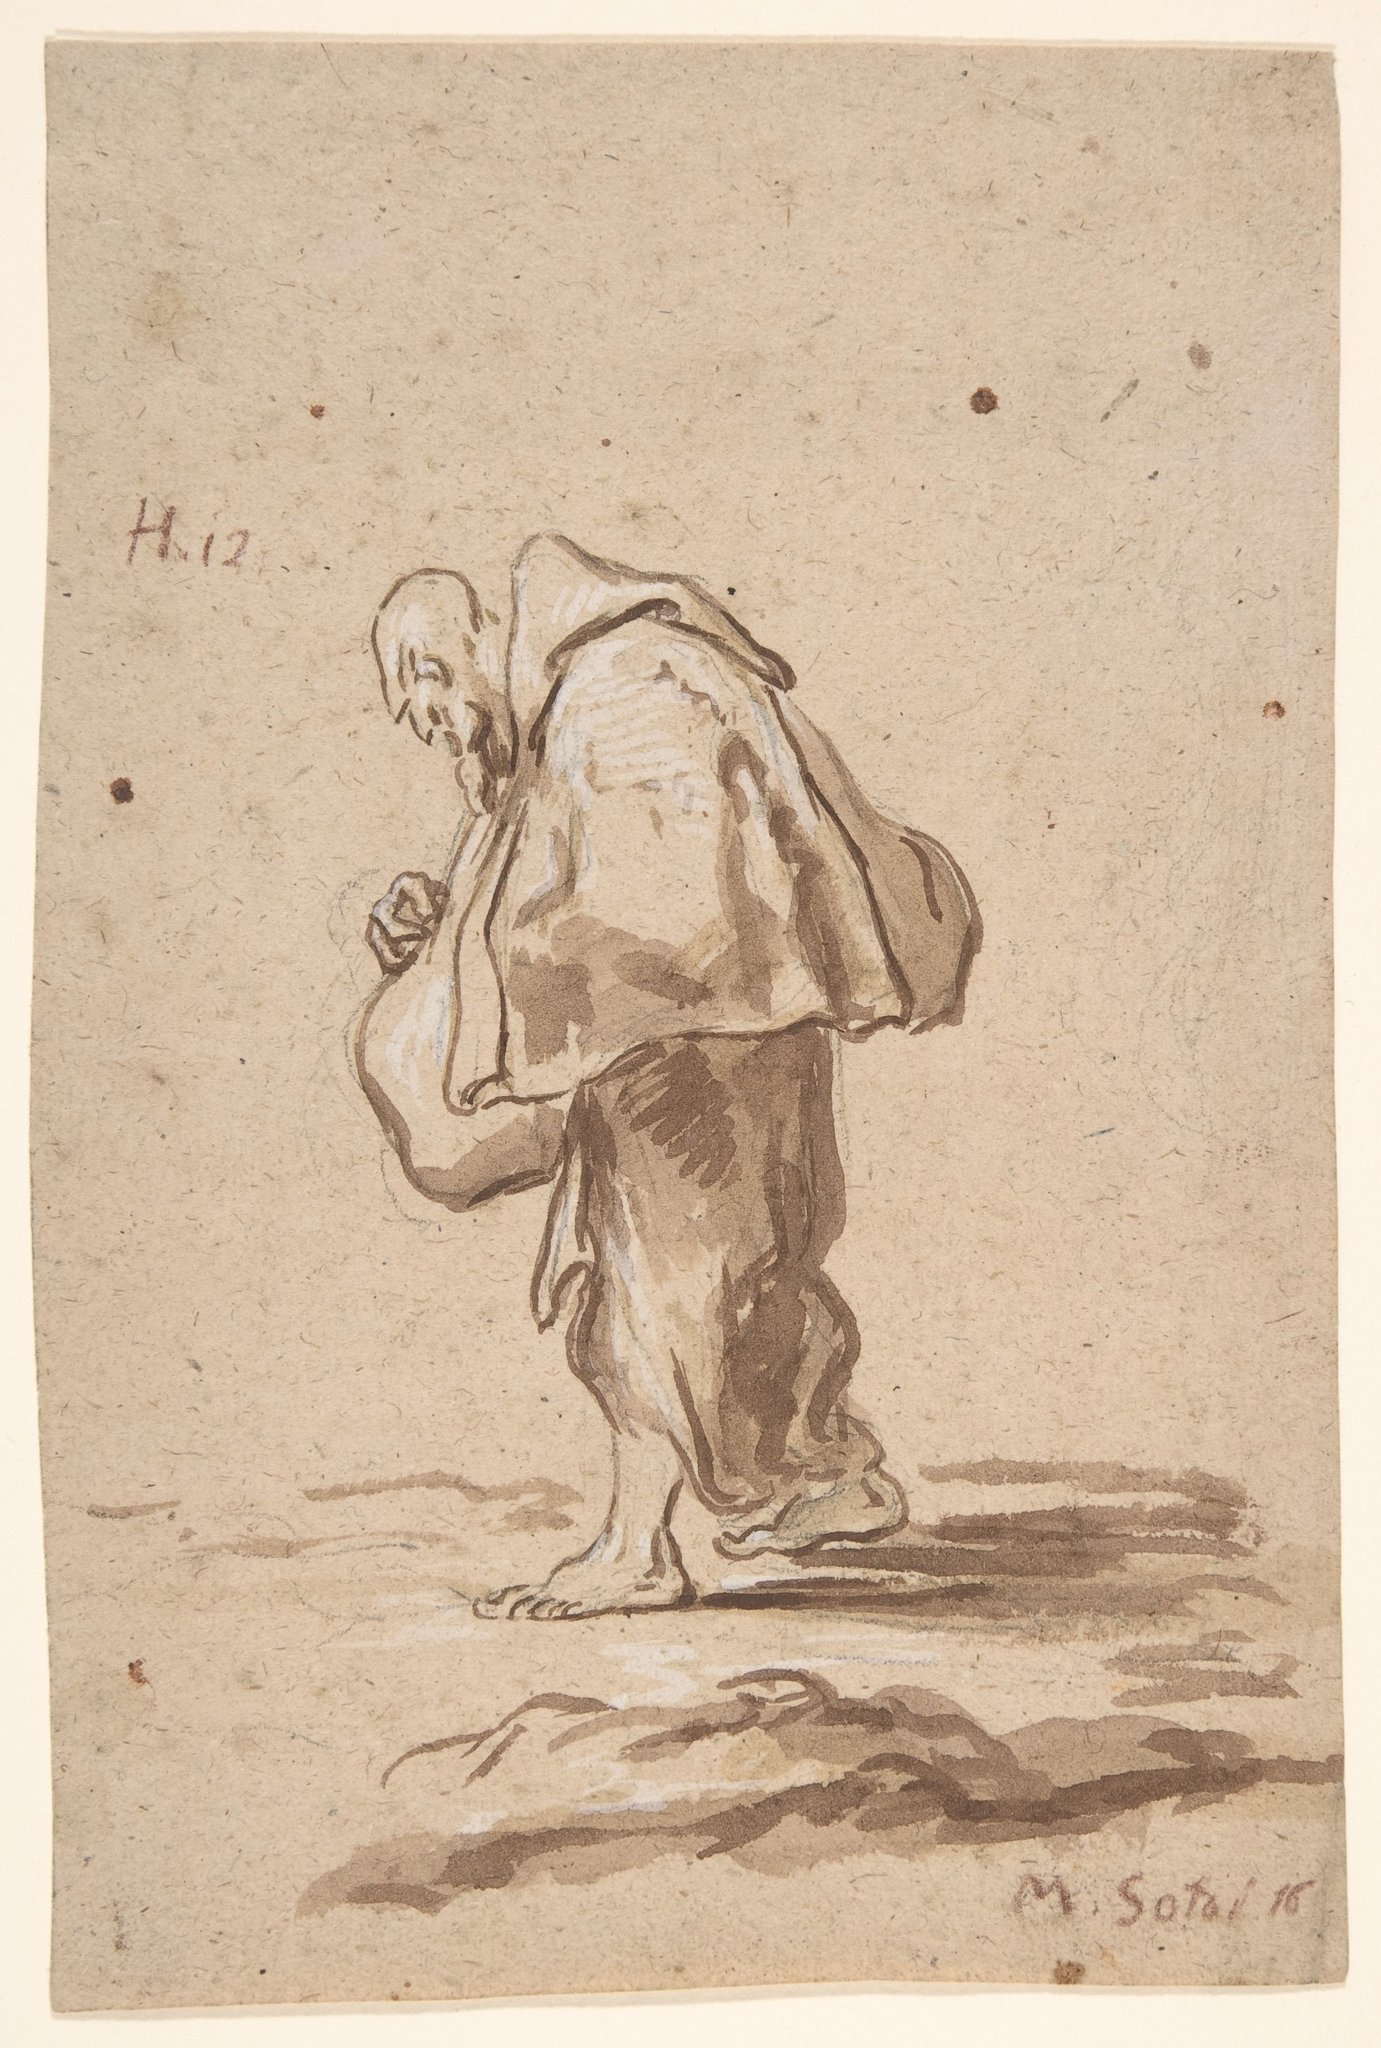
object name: drawing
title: Standing Pilgrim Friar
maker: alessandro magnasco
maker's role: artist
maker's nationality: italian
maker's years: 1667-1749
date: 1705-1720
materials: gouache, paper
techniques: brush, highlighting, wash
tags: men